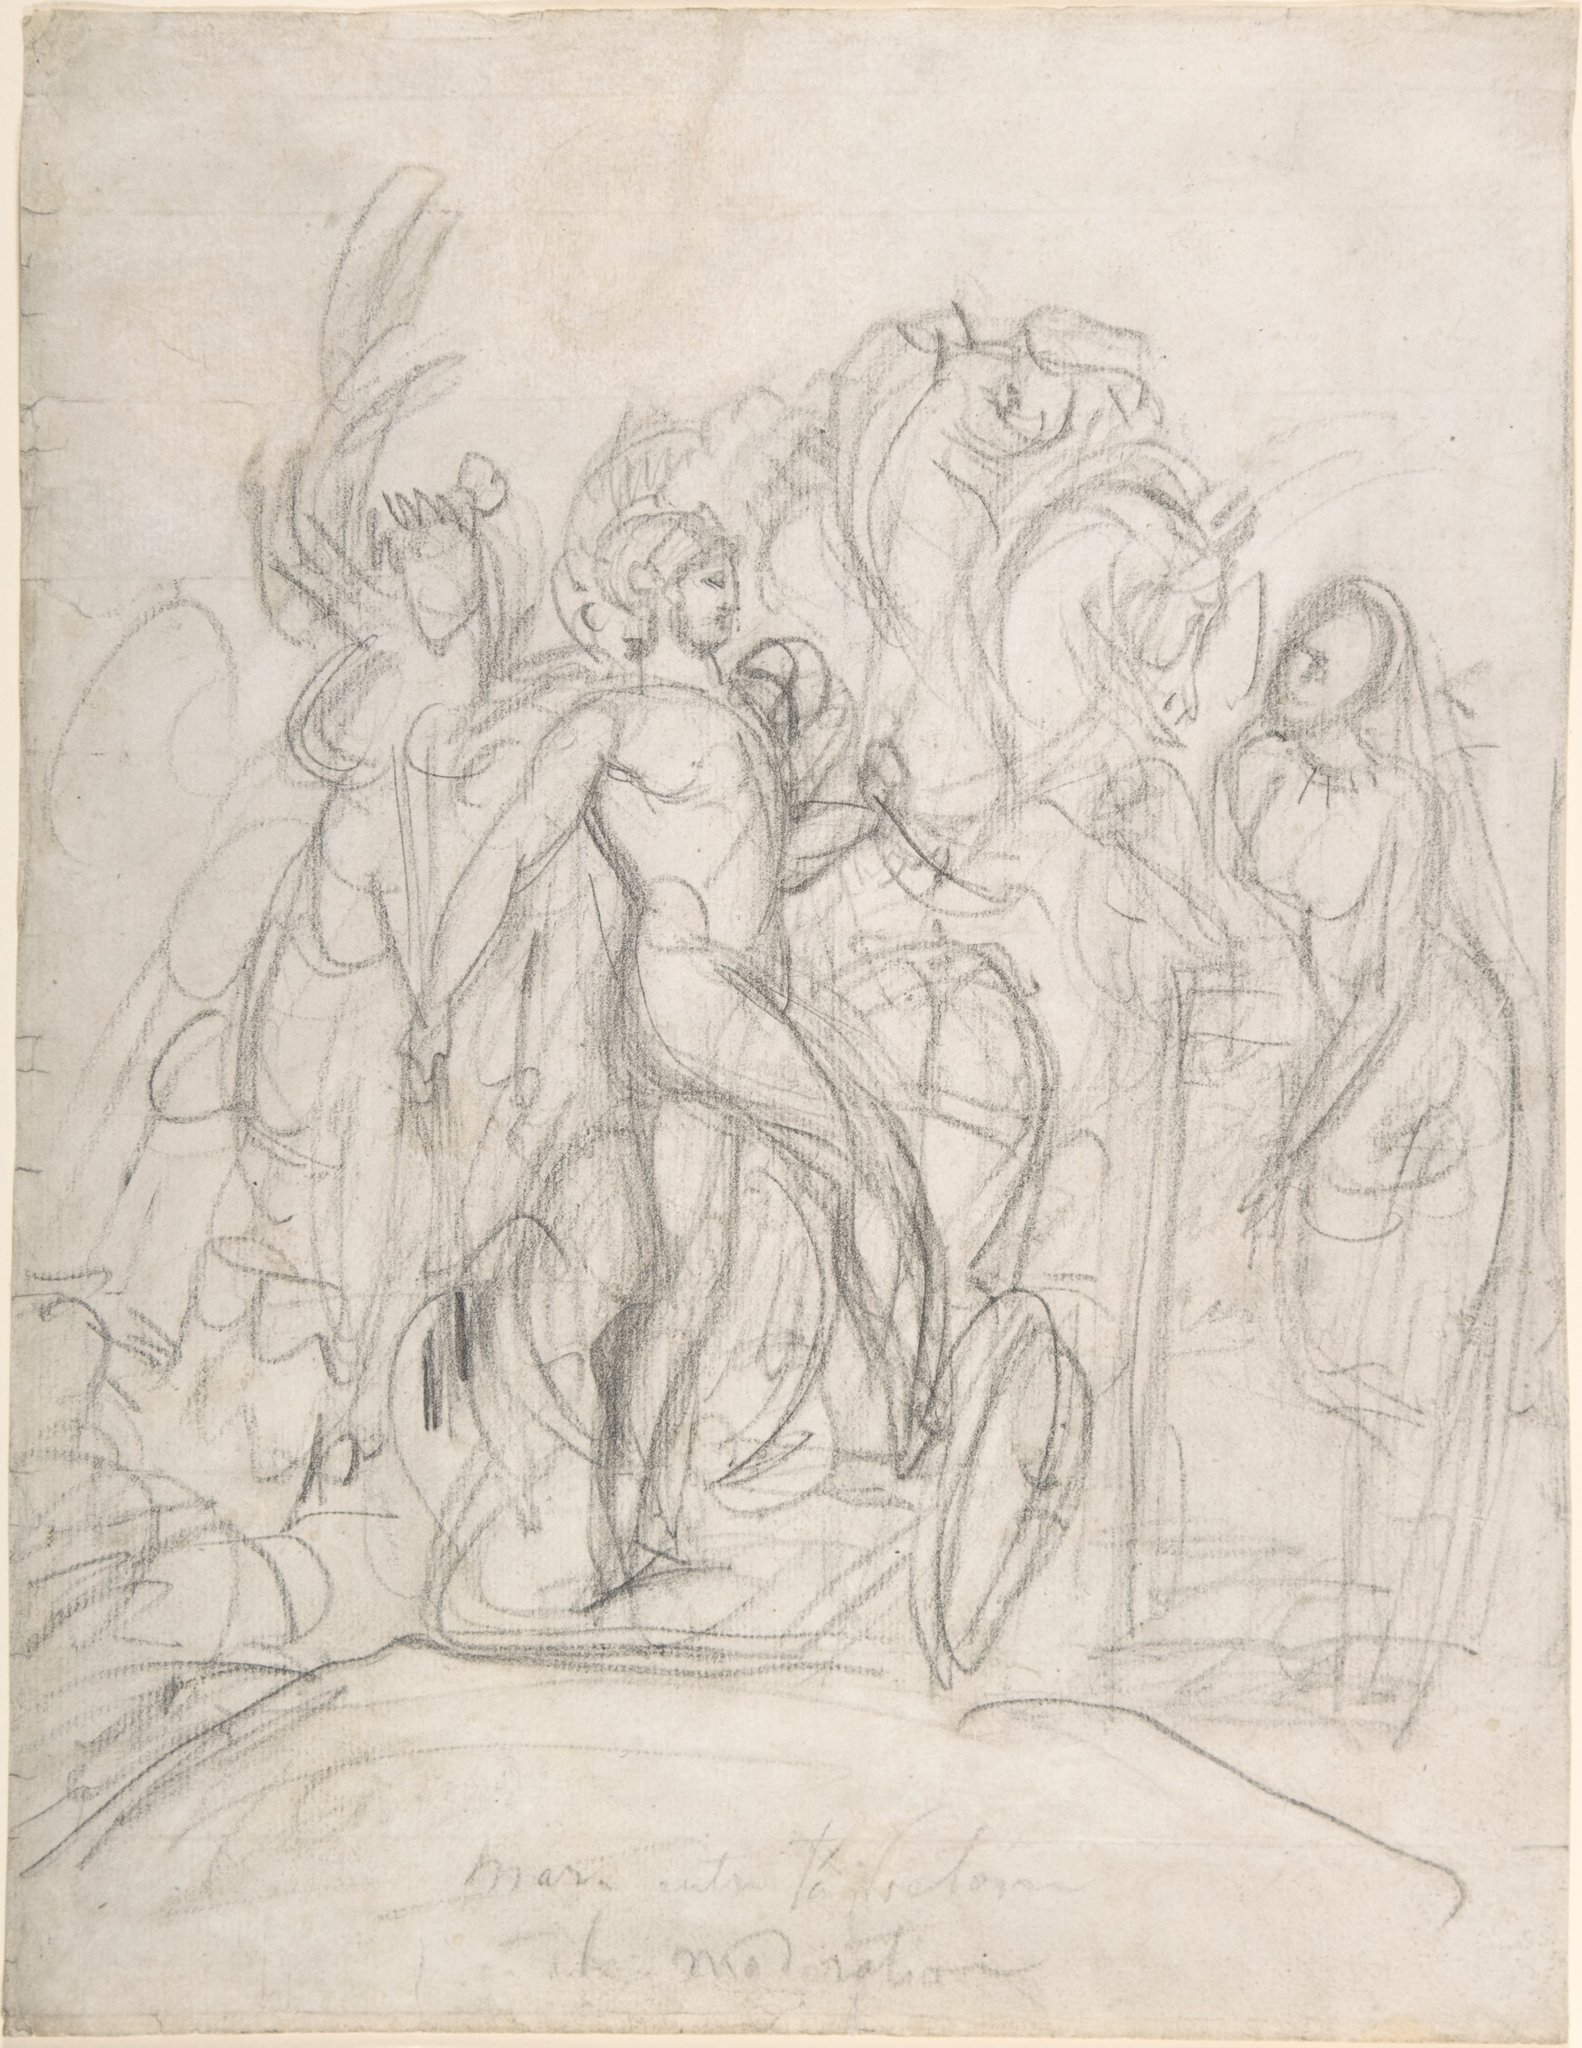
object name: drawing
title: Mars Crowned by Victory and Listening to Moderation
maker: baron antoine jean gros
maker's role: artist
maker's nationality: french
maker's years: 1771-1835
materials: chalk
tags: mars,victory,horses